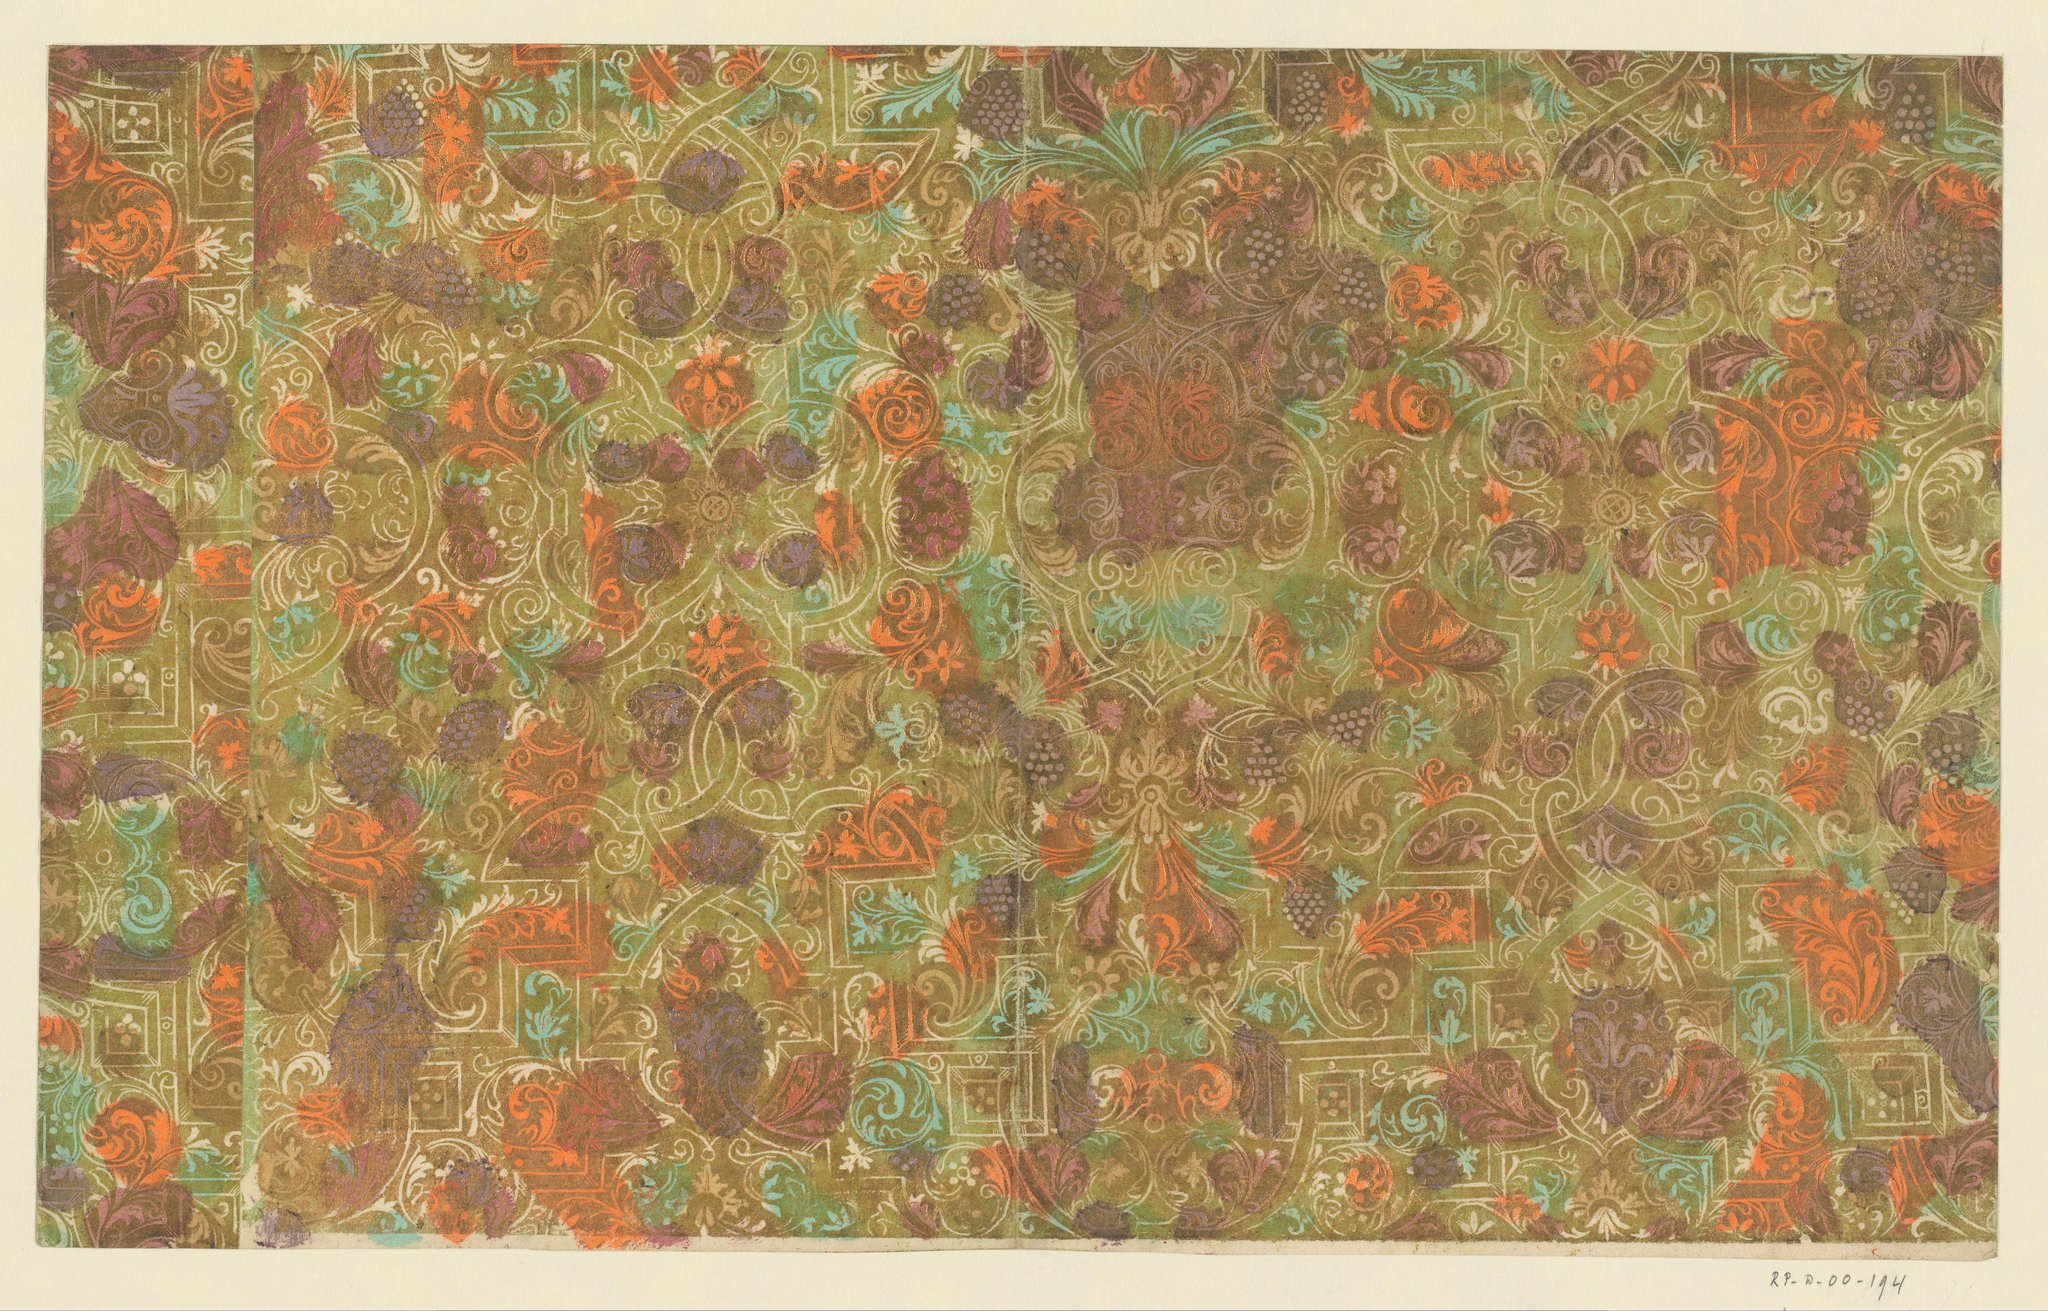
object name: brocade paper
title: Blad met Lodewijk XIV-ornament, bandwerk, ranken met vruchten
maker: johann carl munck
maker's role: ontwerper sierpapier, papiermaker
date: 1750-1794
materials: gold leaf, paint, paper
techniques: relief print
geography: augsburg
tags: ornament ~ geometric motifs, ornament derived from plant forms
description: Blad met Lodewijk XIV-ornament, bandwerk, ranken met vruchten, gebruikt als omslag.